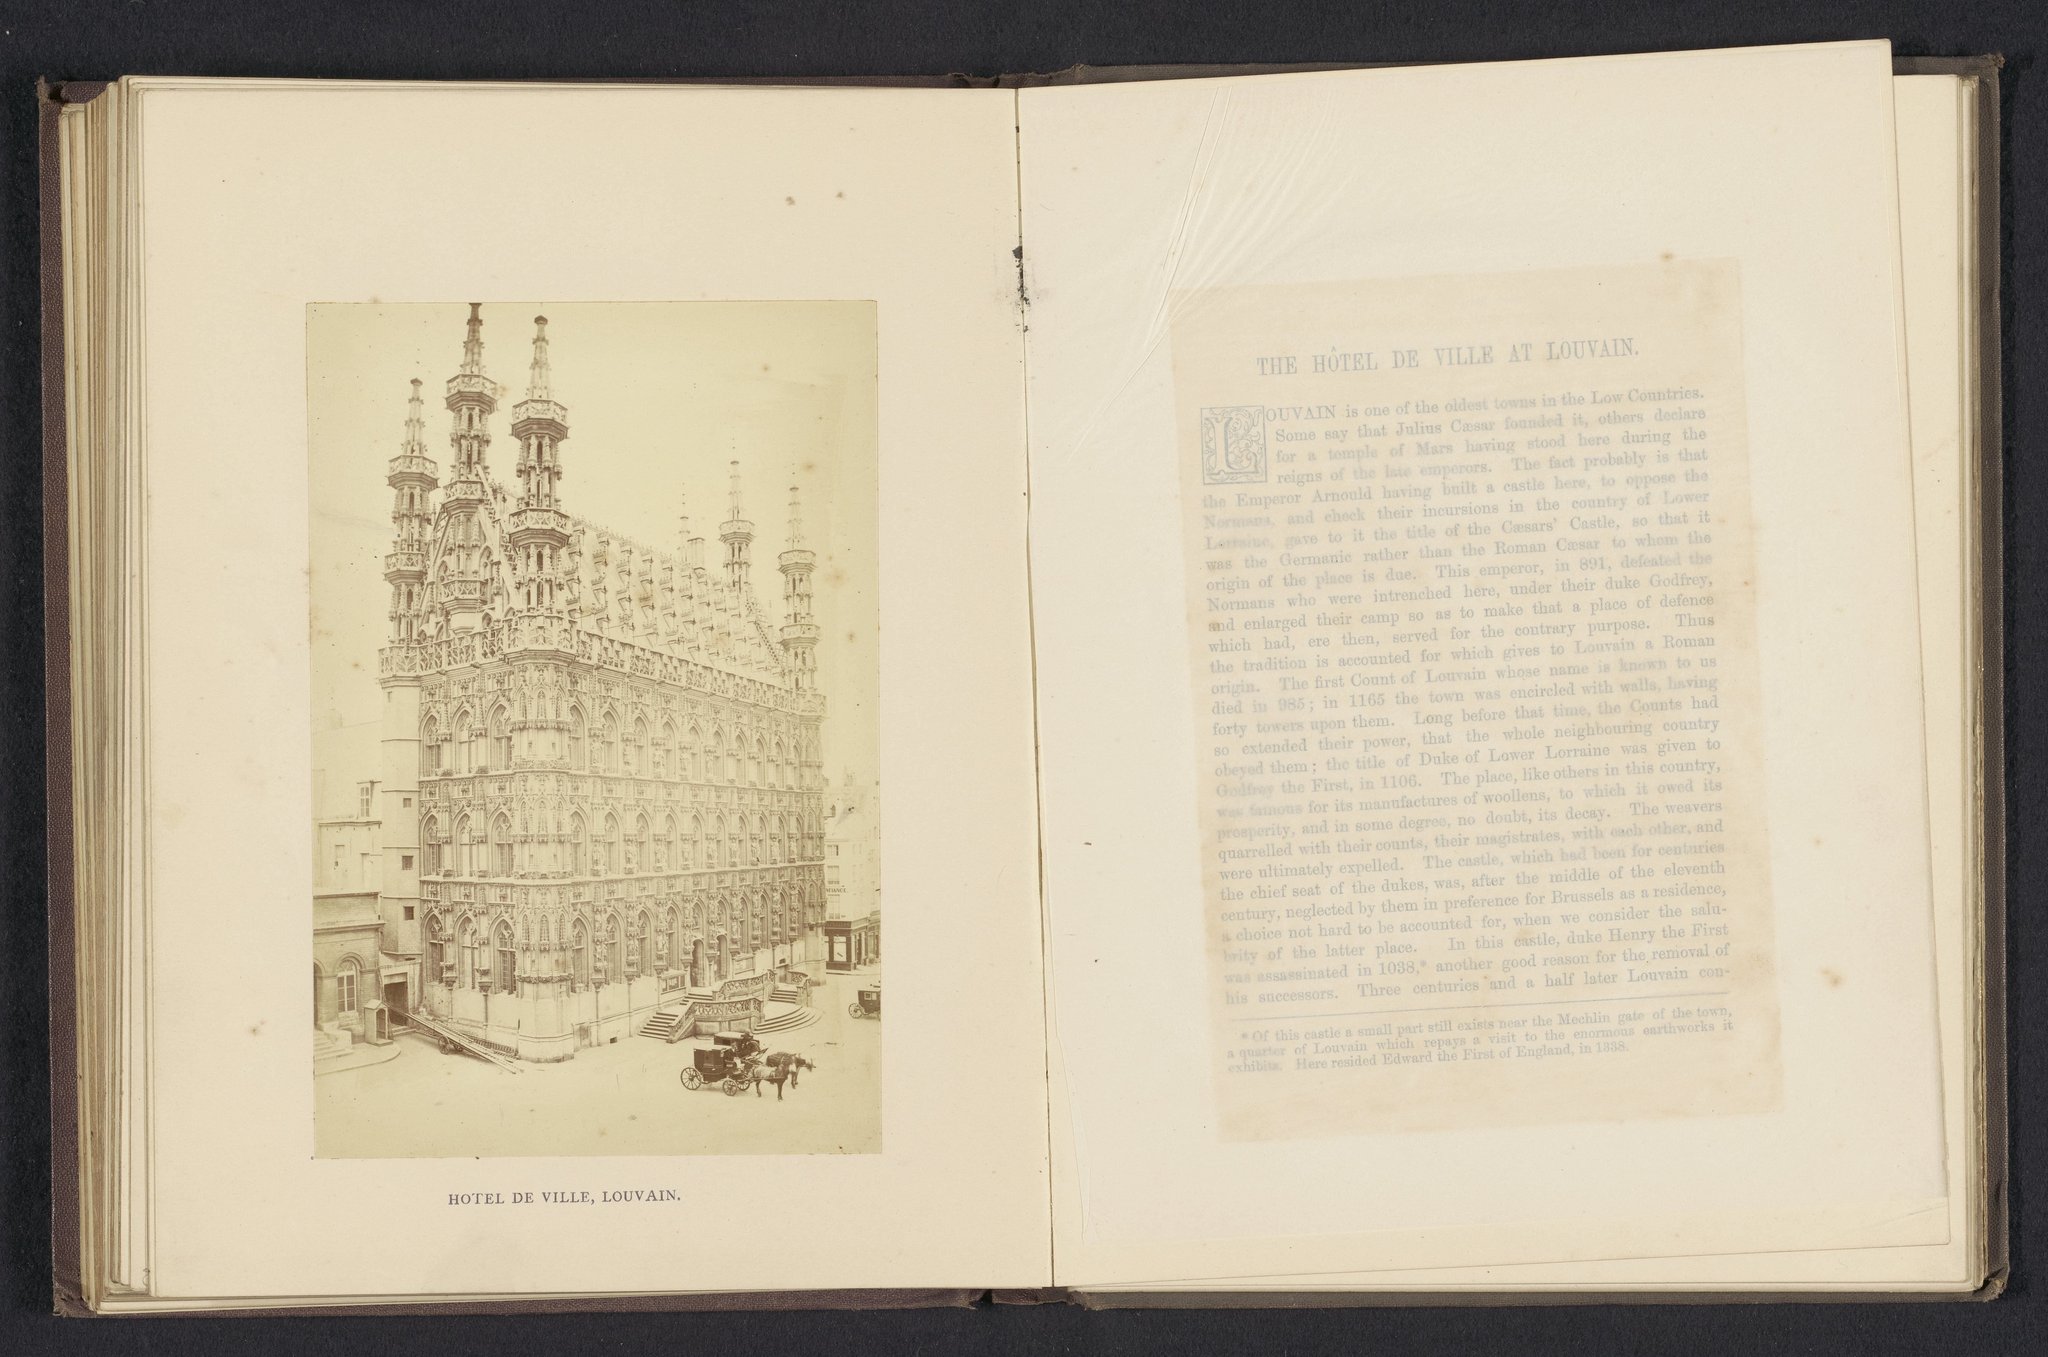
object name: page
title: Hotel de ville, Louvain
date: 1856-1866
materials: photographic support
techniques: albumen print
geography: leuven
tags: townhall, façade (of house or building)